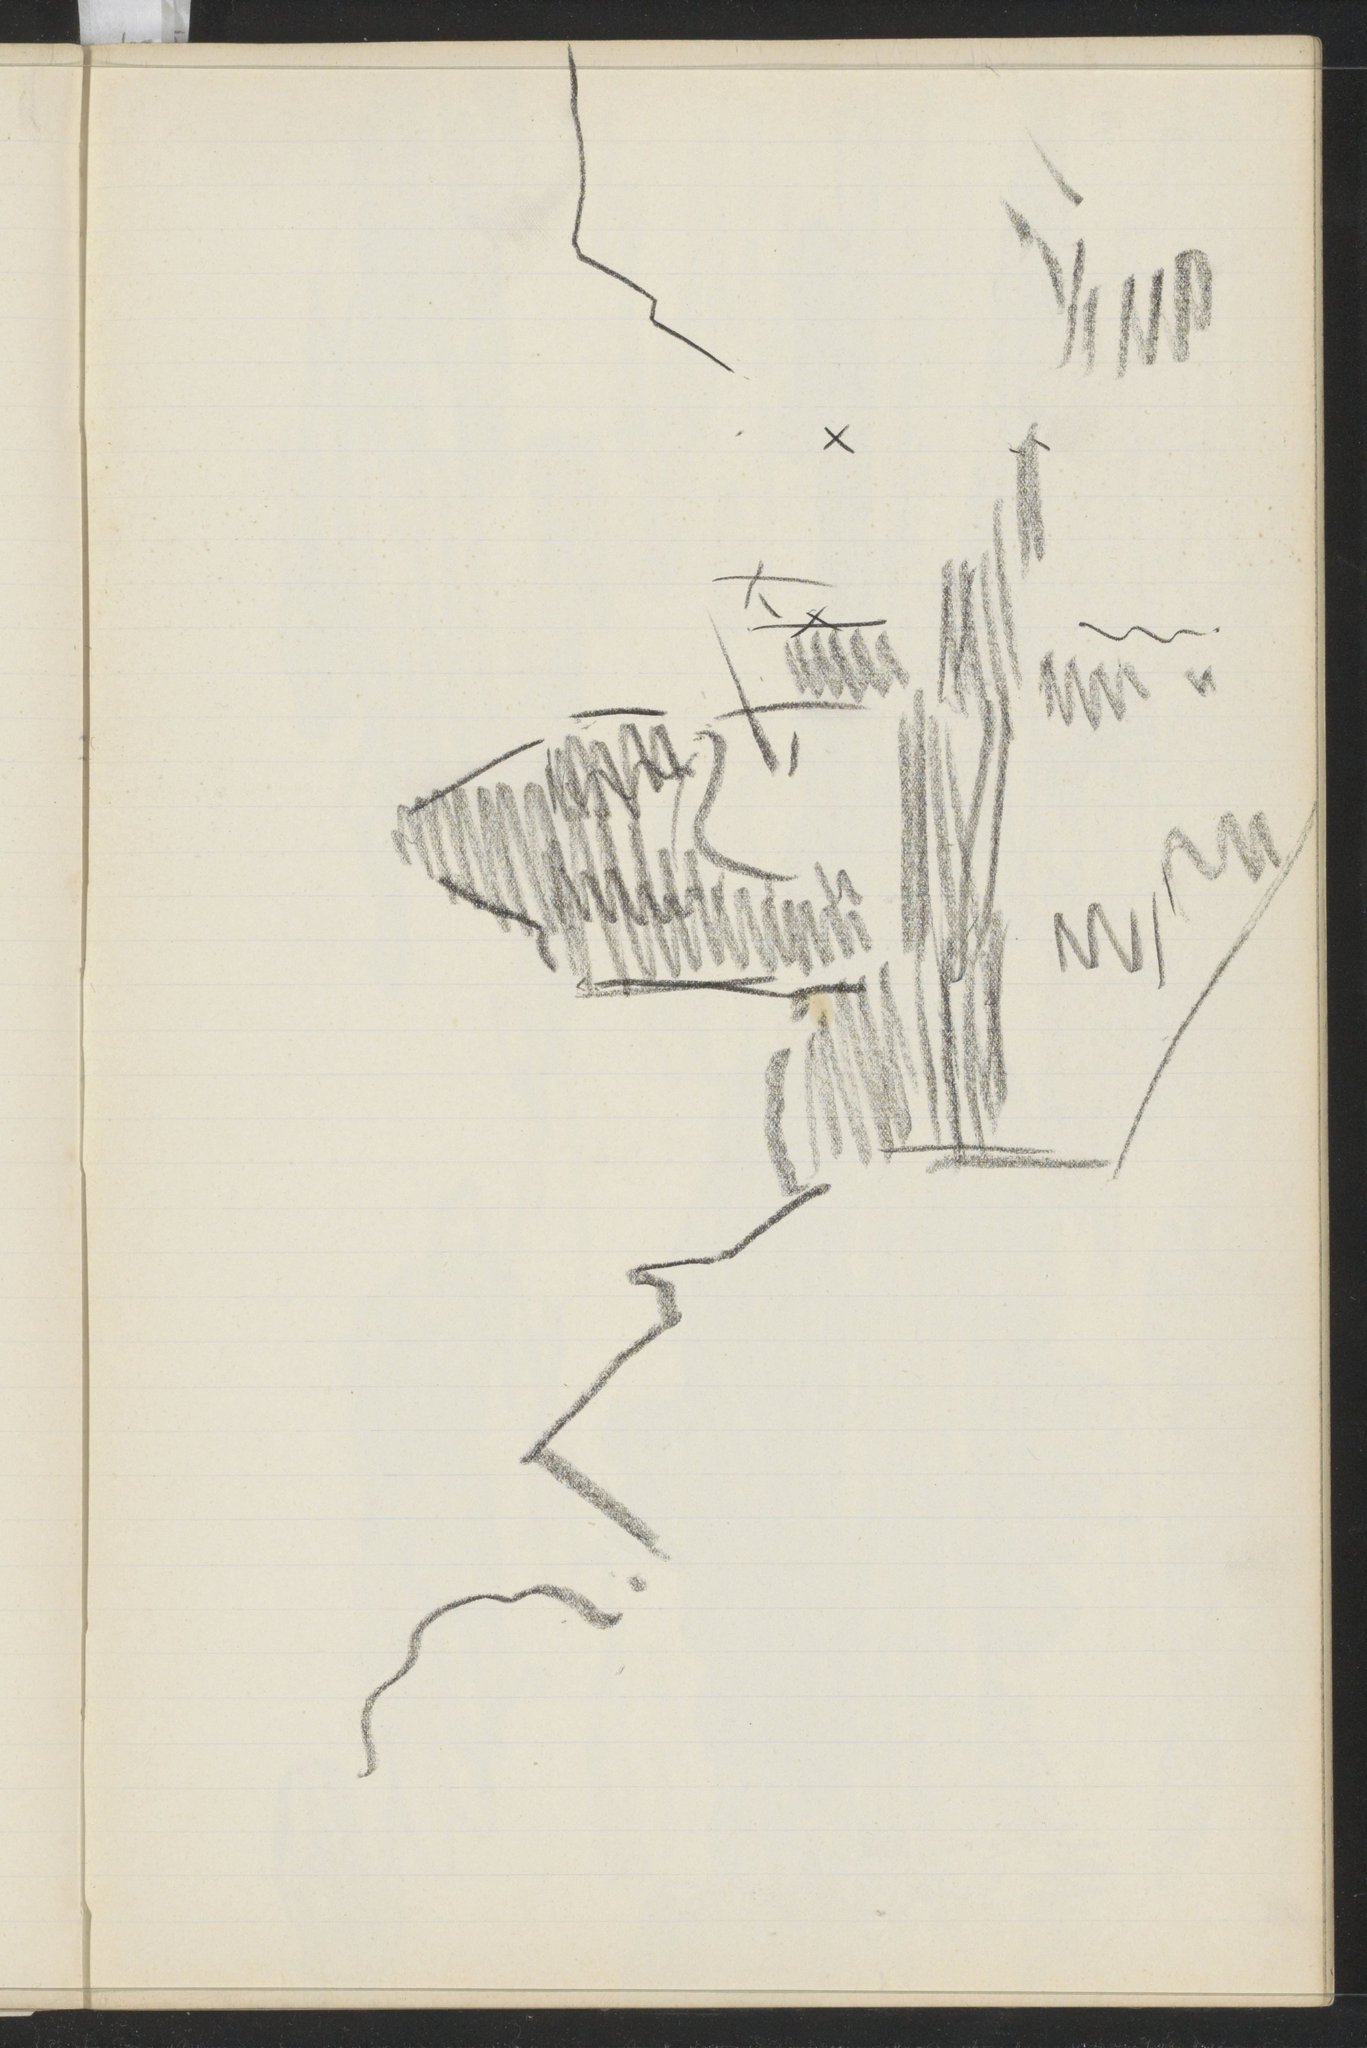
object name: sketchbook leaf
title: Gezicht op Enkhuizen met de stadspoort de Drommedaris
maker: willem bastiaan tholen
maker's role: draughtsman, painter, print maker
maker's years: 1860-1931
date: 1900-1931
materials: chalk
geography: enkhuizen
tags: city-view, and landscape with man-made constructions, towers ~ fortified city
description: Blad 22 recto uit een schetsboek met 55 bladen.